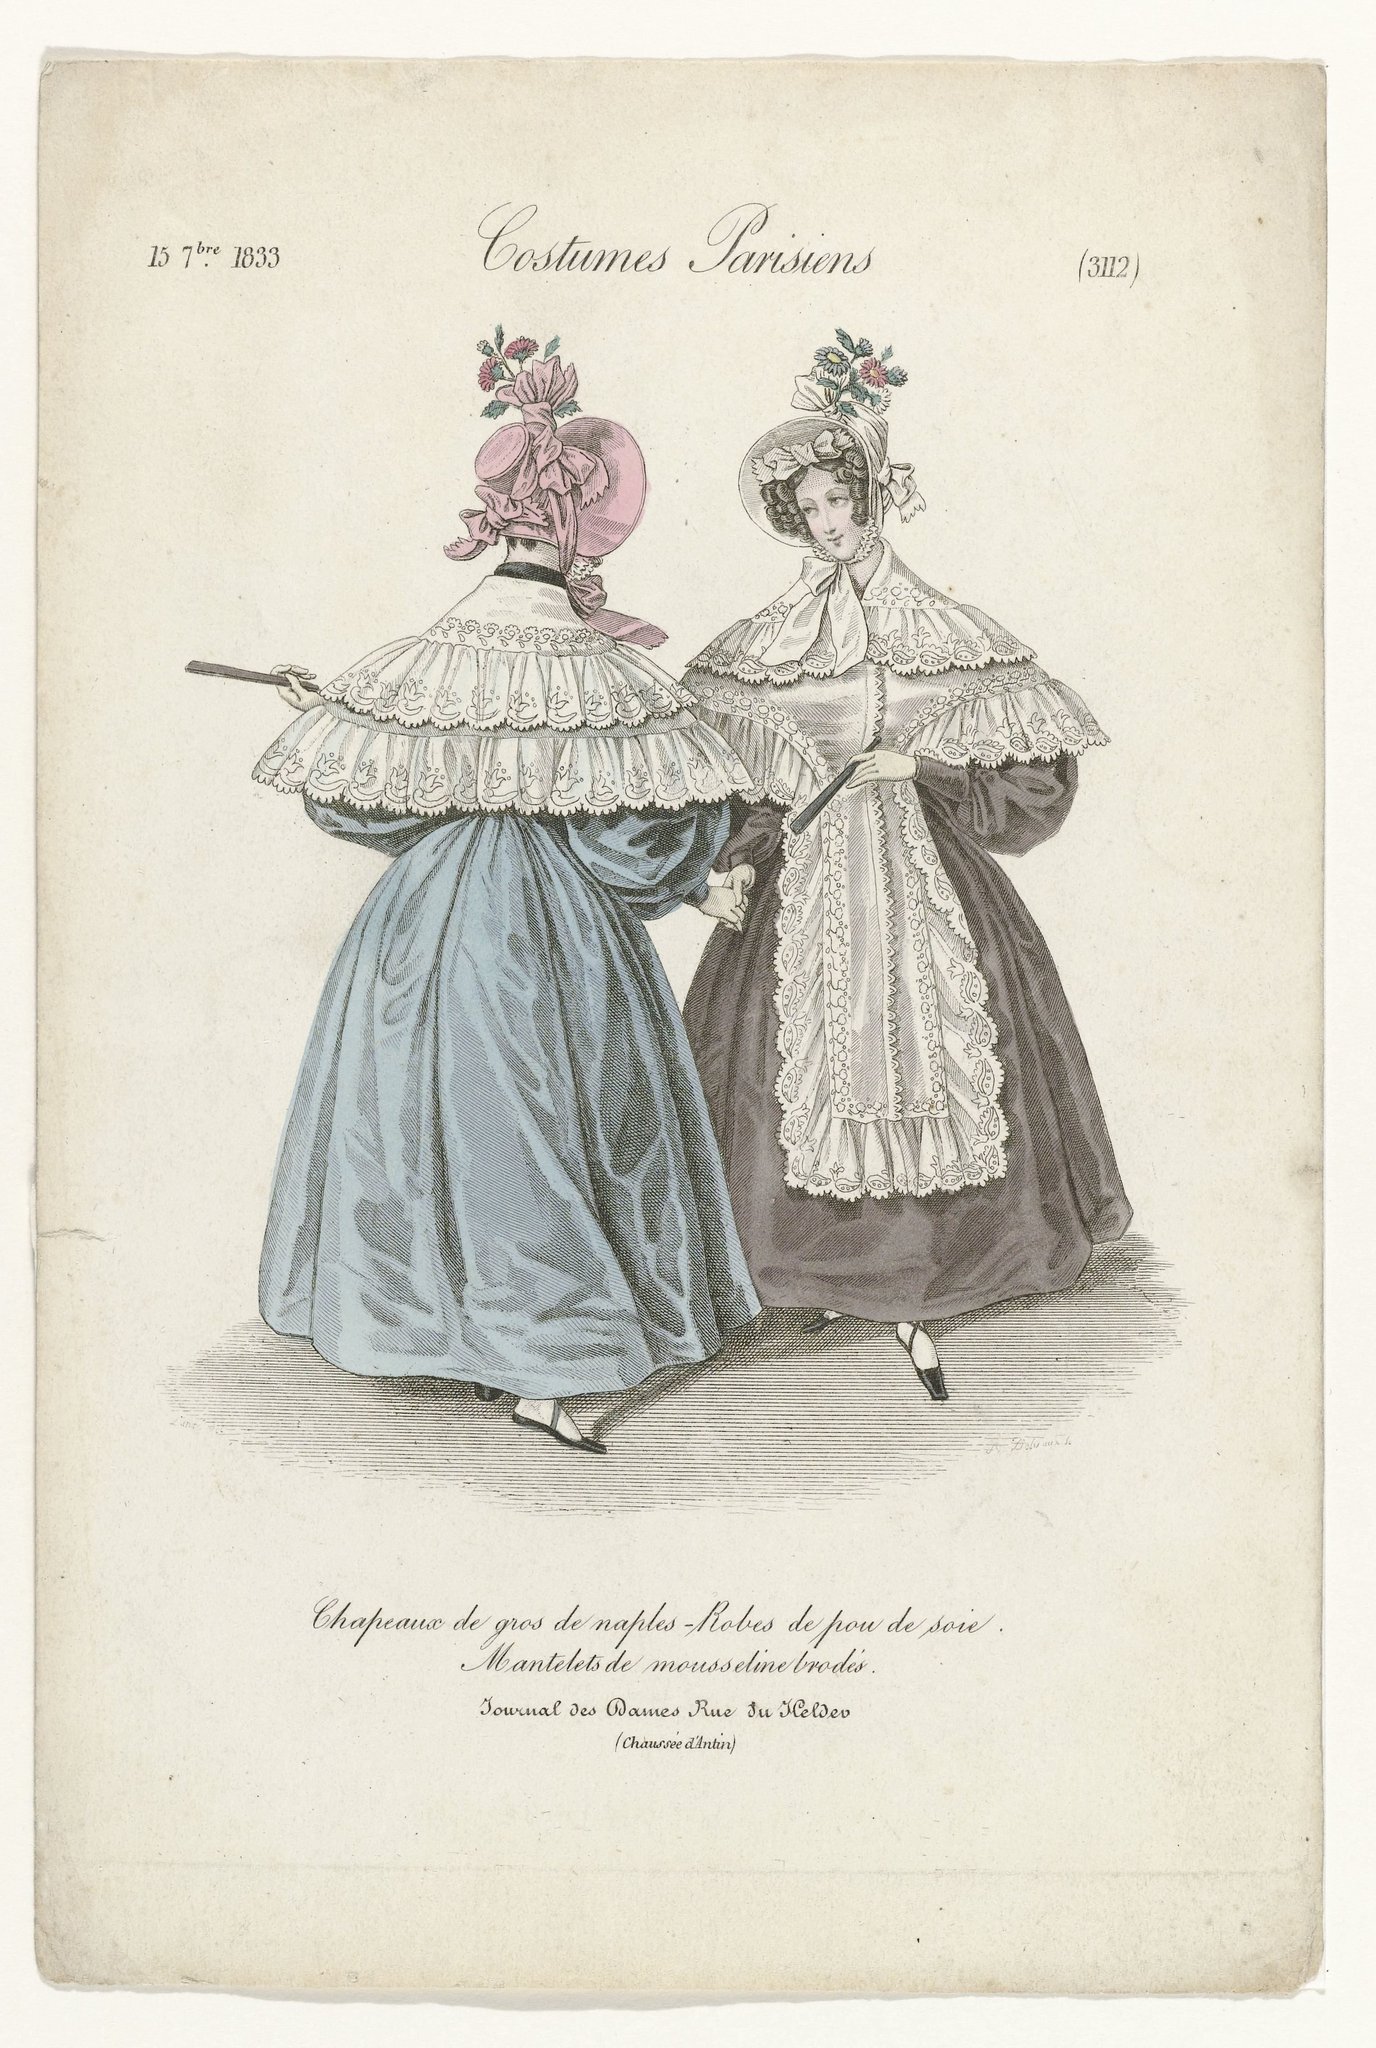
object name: fashion print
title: Journal des Dames et des Modes, Costumes Parisiens, 15 septembre 1833, (3112): Chapeaux de gros de naples (...)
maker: august delvaux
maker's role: print maker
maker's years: 1786-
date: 1833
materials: paper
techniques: engraving, hand coloring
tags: shaking hands, 'dextrarum junctio', embroidery (ornamentation) (+ women's clothes), clothing for the upper part of the body (mantelet) (+ women's clothes), fashion plates, head-gear: hat (+ women's clothes), dress, gown (+ women's clothes)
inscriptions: caption: ‘Chapeaux de gros de naples - Robes de pou de soie. Mantelets de mousseline brodés.’, title: ‘Costumes Parisiens.’, address: ‘Journal des Dames Rue du Helder (Chaussée d'Antin)’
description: Twee vrouwen geven elkaar de hand. Hoeden van 'gros de naples'. Japonnen van 'pou de soie'. Mantelets van geborduurde mousseline. De prent maakt deel uit van het modetijdschrift Journal des Dames et des Modes, Parijs, 1797-1839.